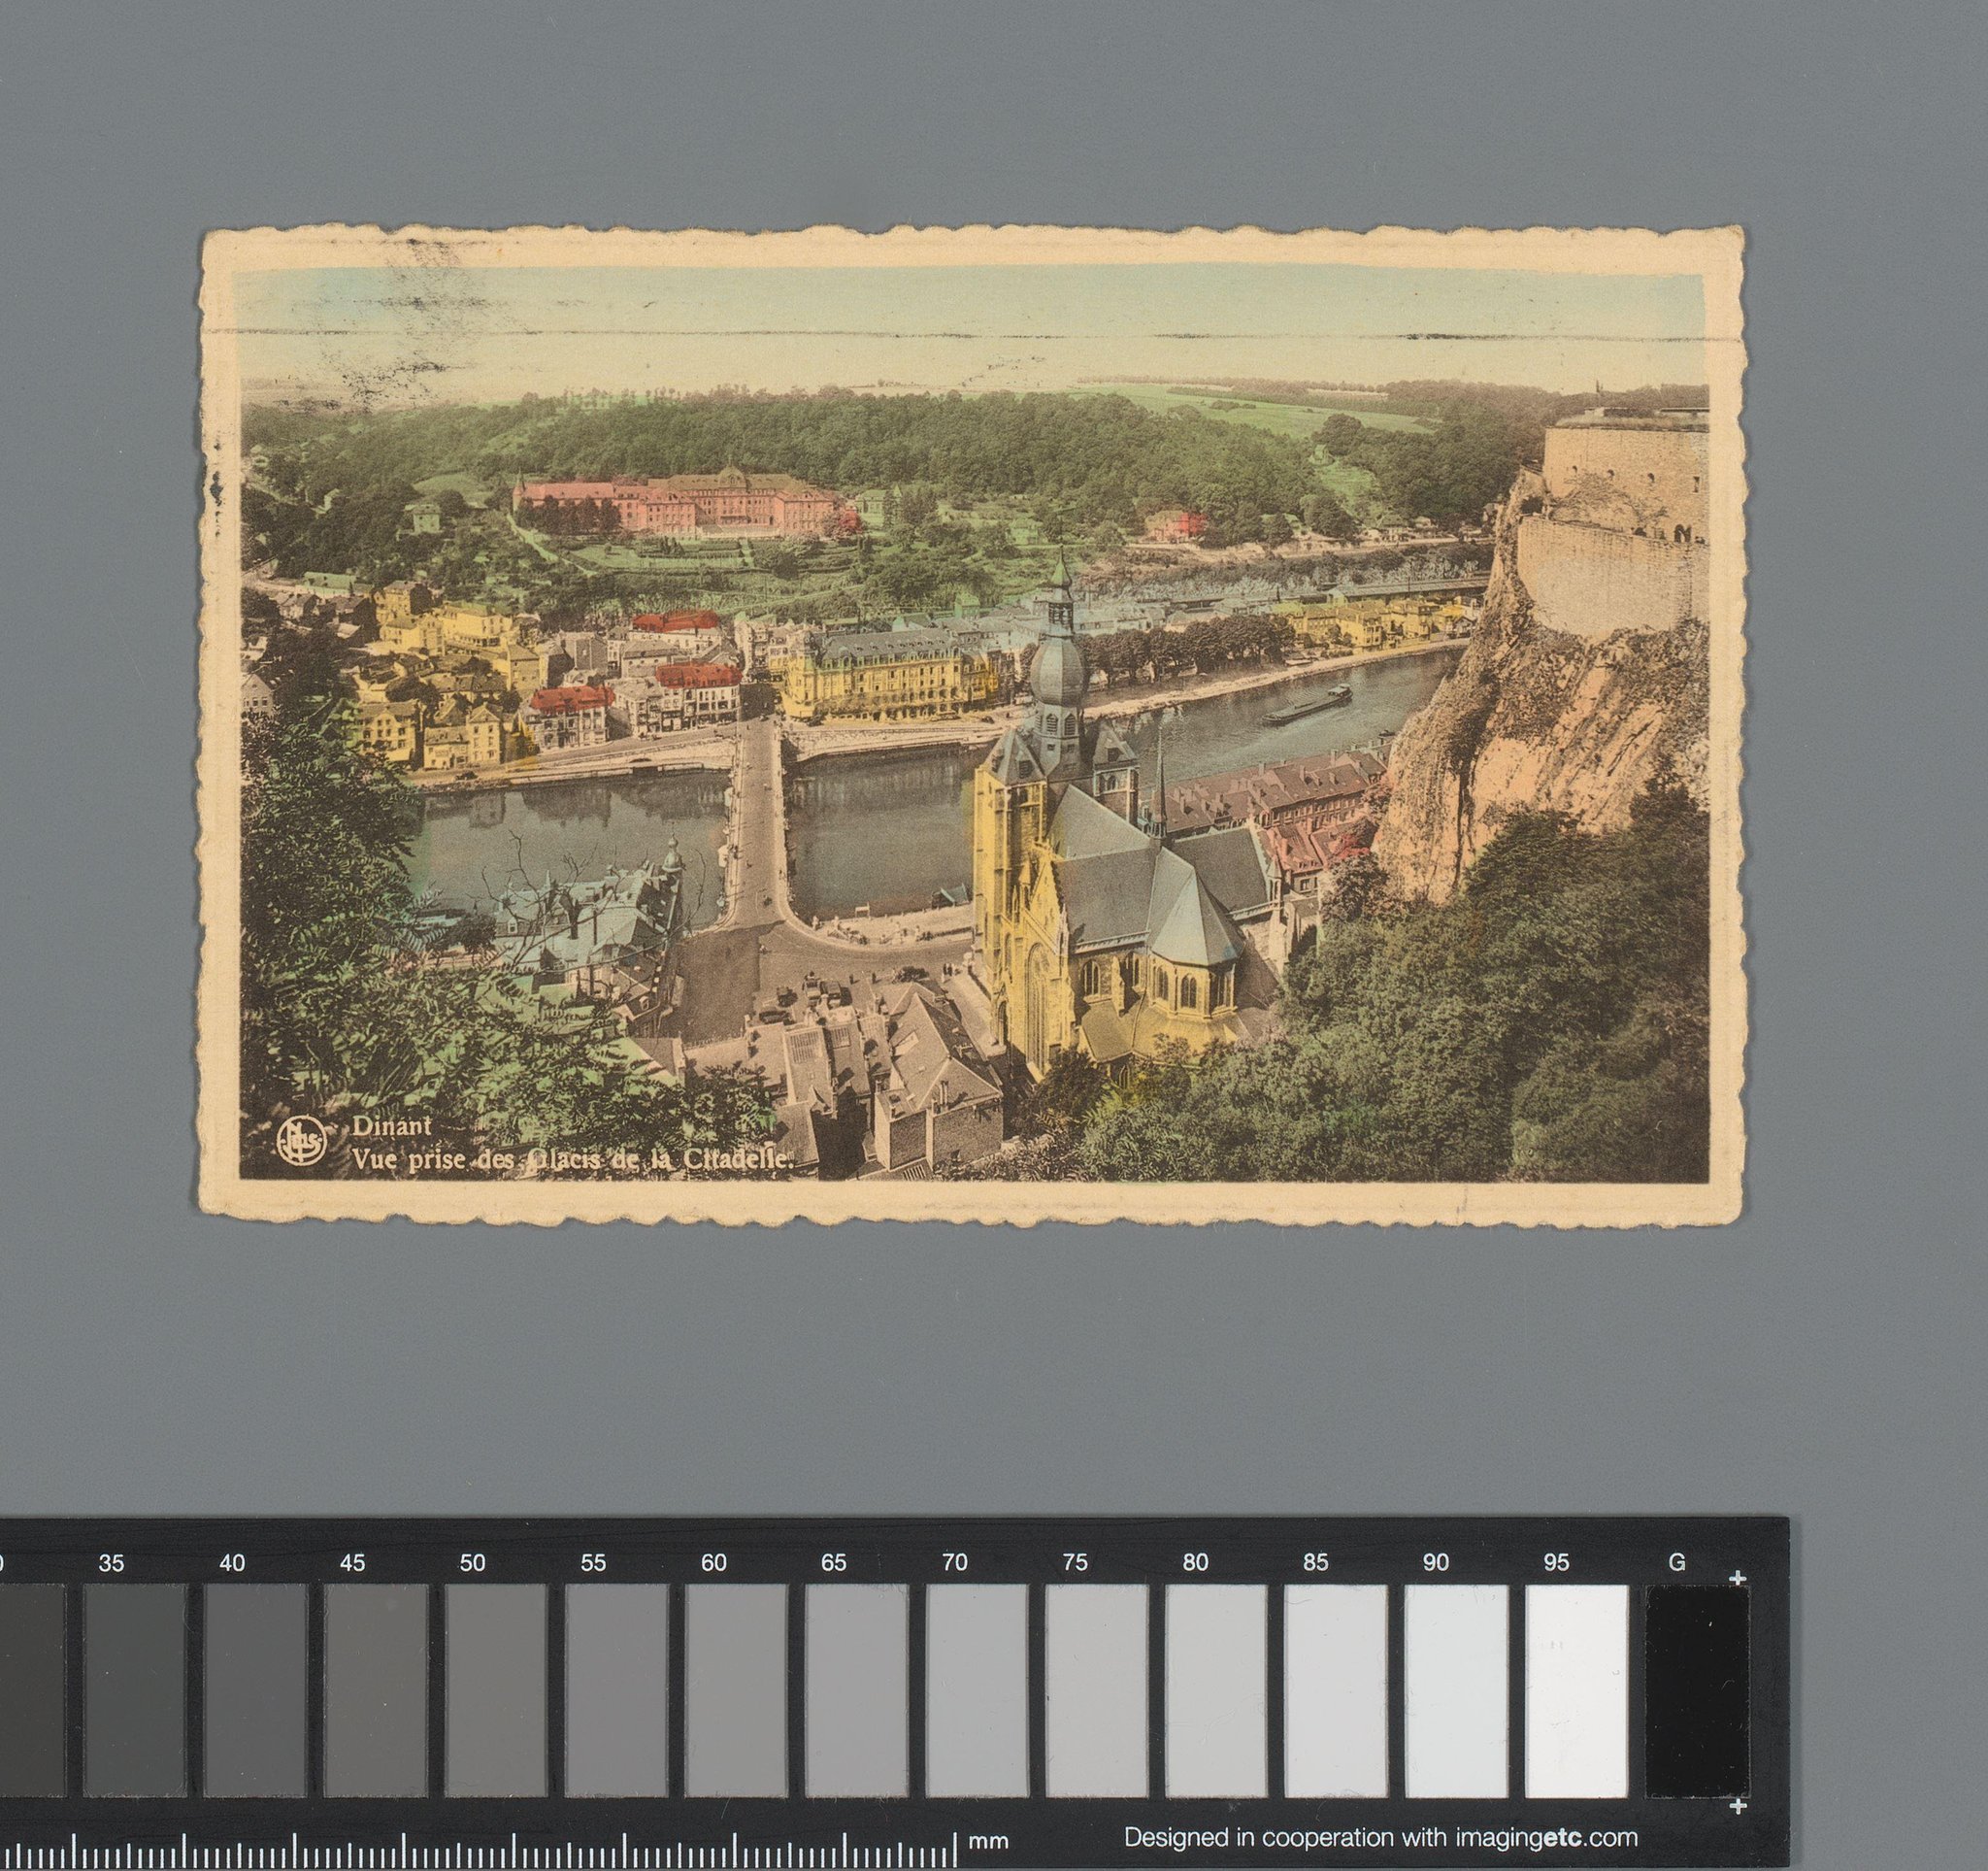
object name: ansichtkaart, prentbriefkaart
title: Vue prise des Glacis de la Citadelle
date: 1954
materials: paper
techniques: photograph, lithograph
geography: brussels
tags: city-view in general; 'veduta'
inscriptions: inscription: ‘[...]/ Willy/ Fam. J. de Boer/ portrait [?] Rijkspolitie/ W. [...]/ Breezand/ Pays Bas, N. H.’, inscription: ‘série 33, no 28’